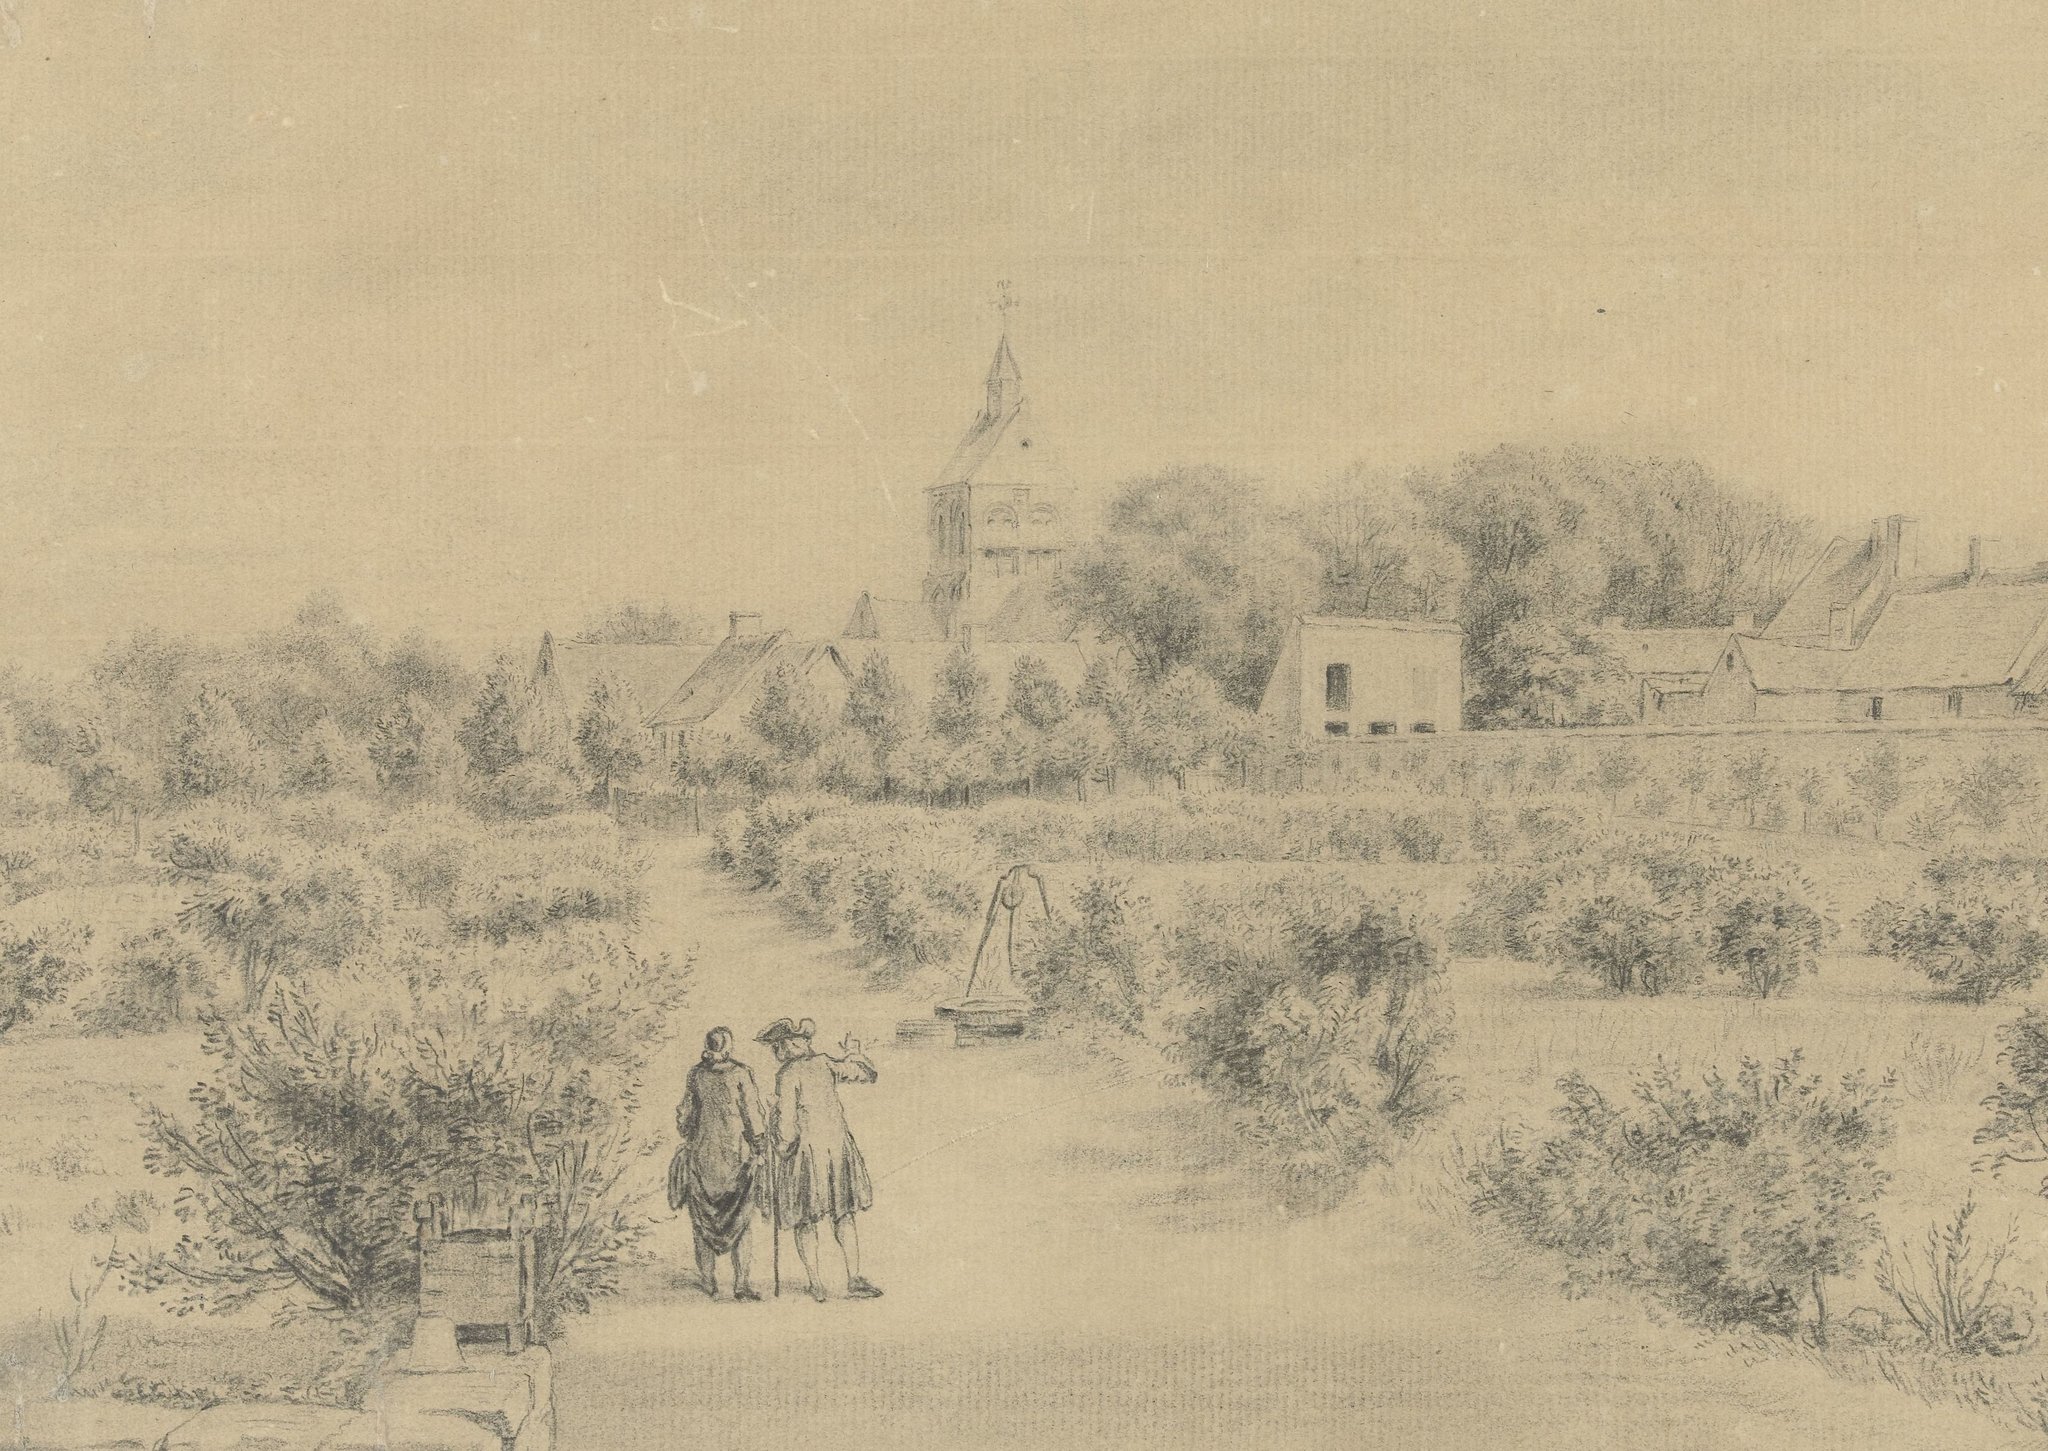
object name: drawing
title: Gezicht op het dorp Marigny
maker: charles nicolas cochin (ii)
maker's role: draughtsman, print maker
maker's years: 1715-1790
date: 1760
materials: chalk, paper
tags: prospect of village, silhouette of village (+ city(-scape) with figures, staffage)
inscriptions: annotation, recto, lower centre, on the old mount, pen and black ink: ‘VUE du Clocher et partie du Village de MARIGNY prise du Sallon du Château. par M. Cochin. 1760.’, collector's mark, verso, lower centre: Lugt 2228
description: Gezicht op het dorp Marigny, op de weg erheen wandelen een heer met steek en een curé.